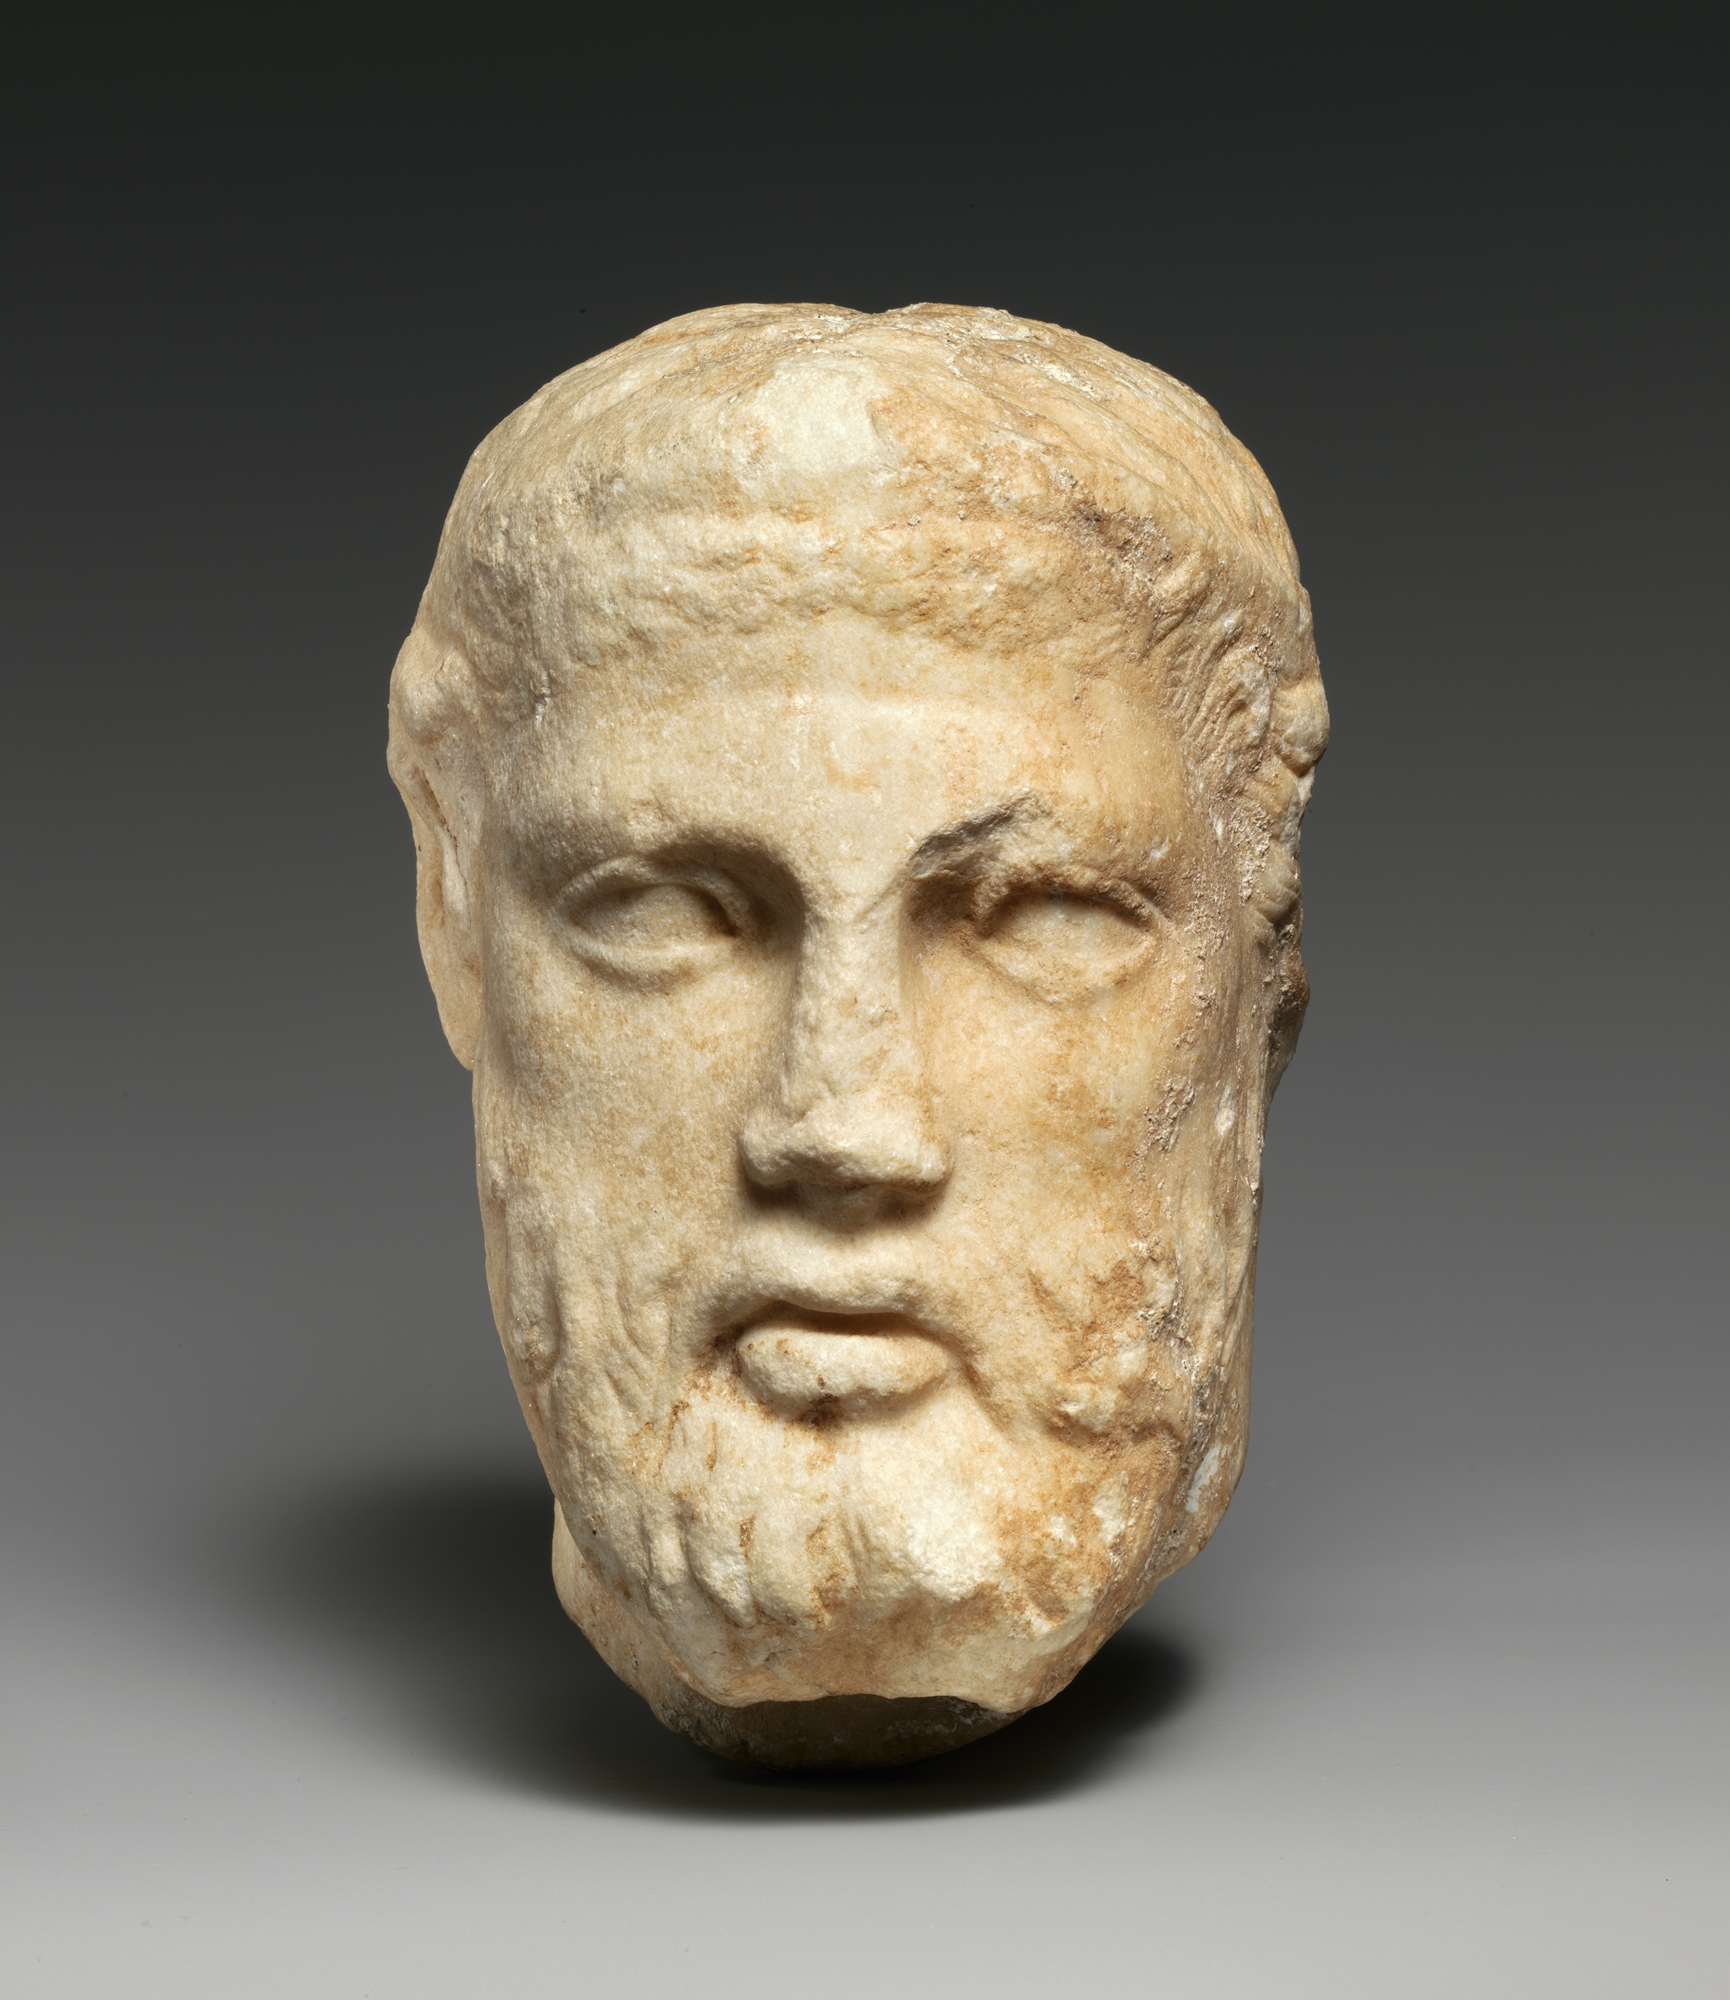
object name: head of a man from a herm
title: Marble head of a bearded man from a herm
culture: greek, attic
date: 450-425 BCE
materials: marble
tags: heads,men